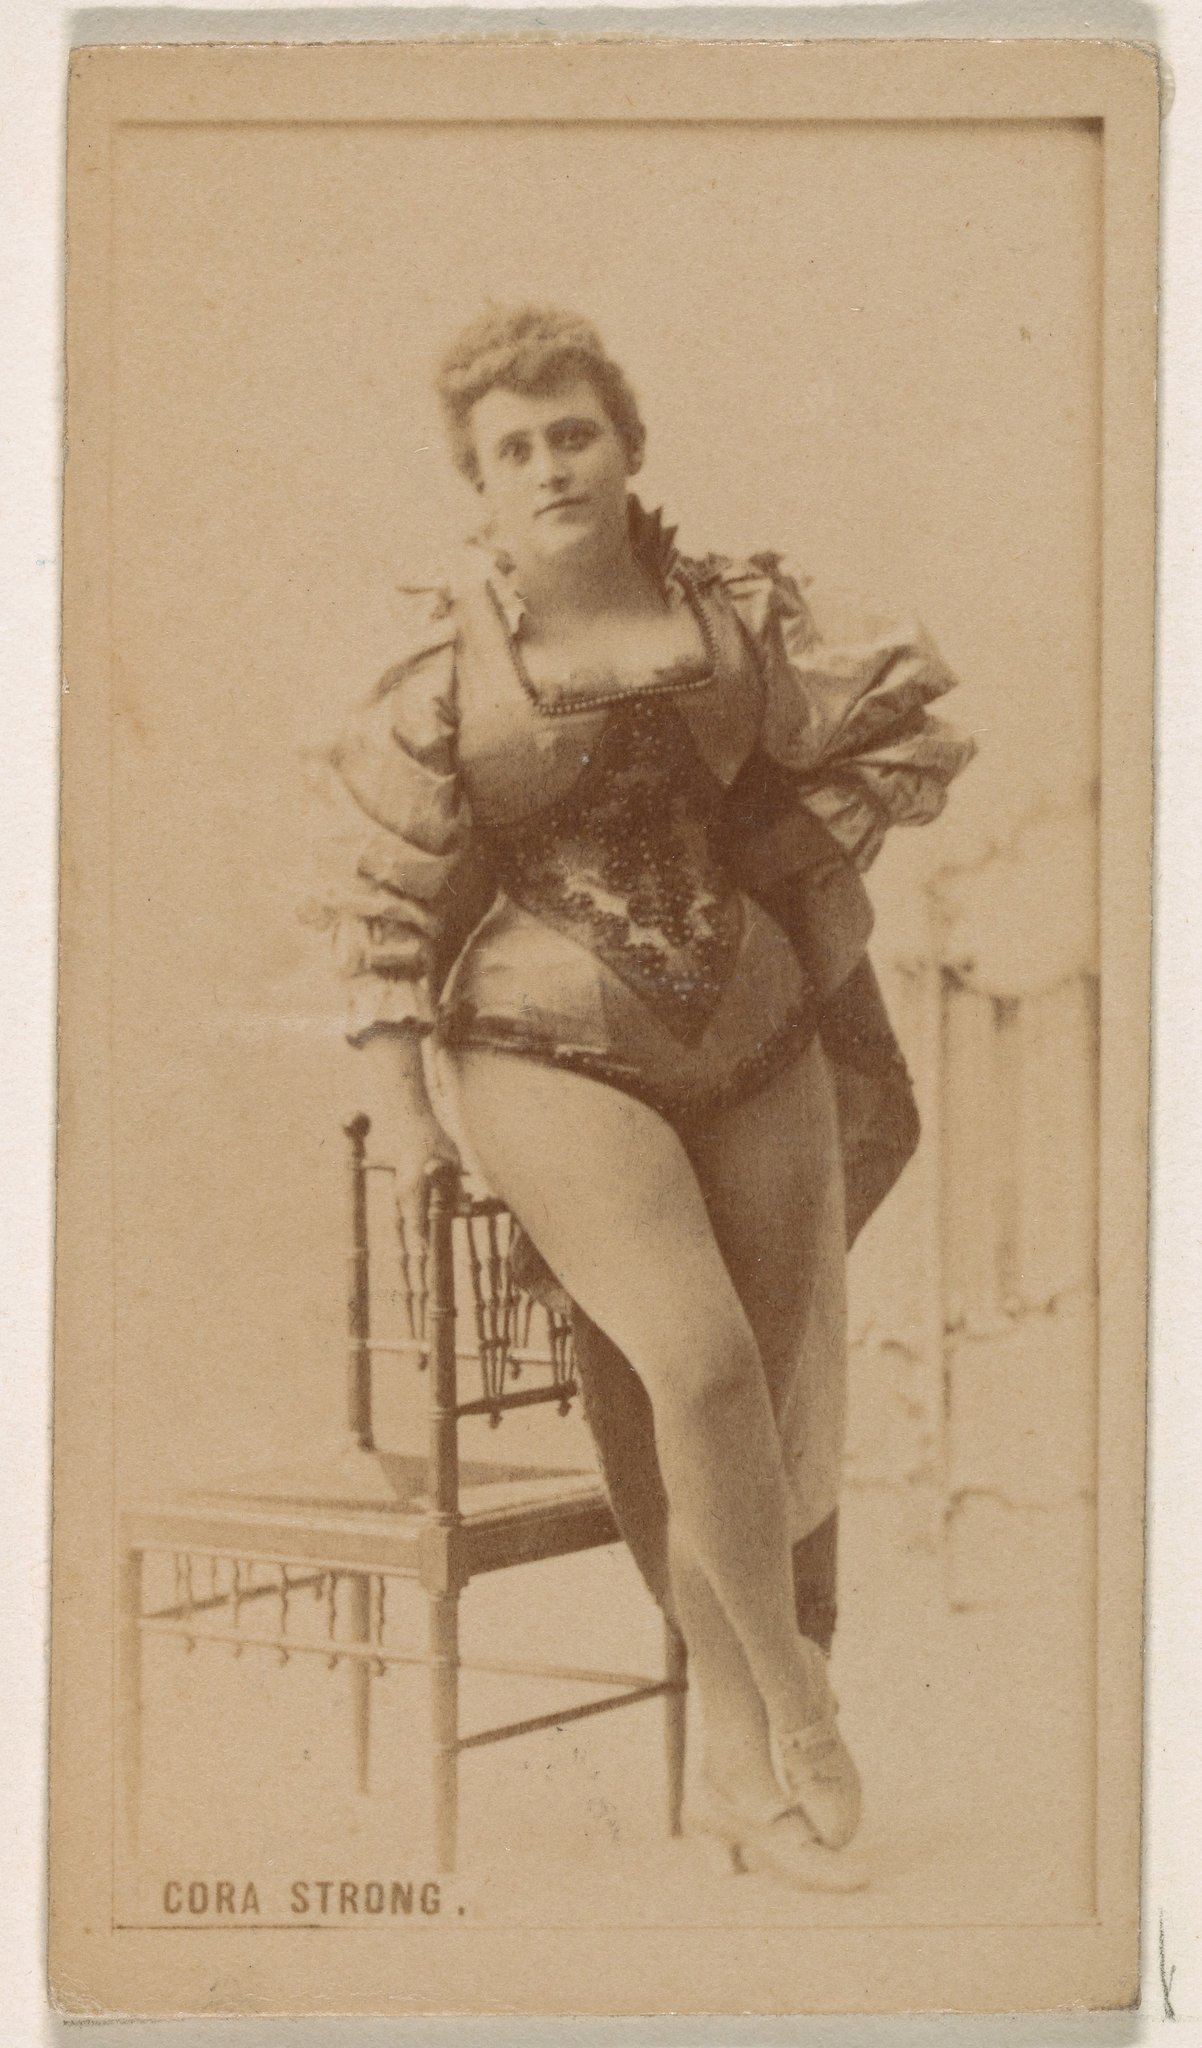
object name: photograph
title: Cora Strong, from the Actresses series (N245) issued by Kinney Brothers to promote Sweet Caporal Cigarettes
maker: kinney brothers tobacco company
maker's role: publisher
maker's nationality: american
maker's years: 1869-2011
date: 1890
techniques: albumen silver print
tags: portraits,women,actresses